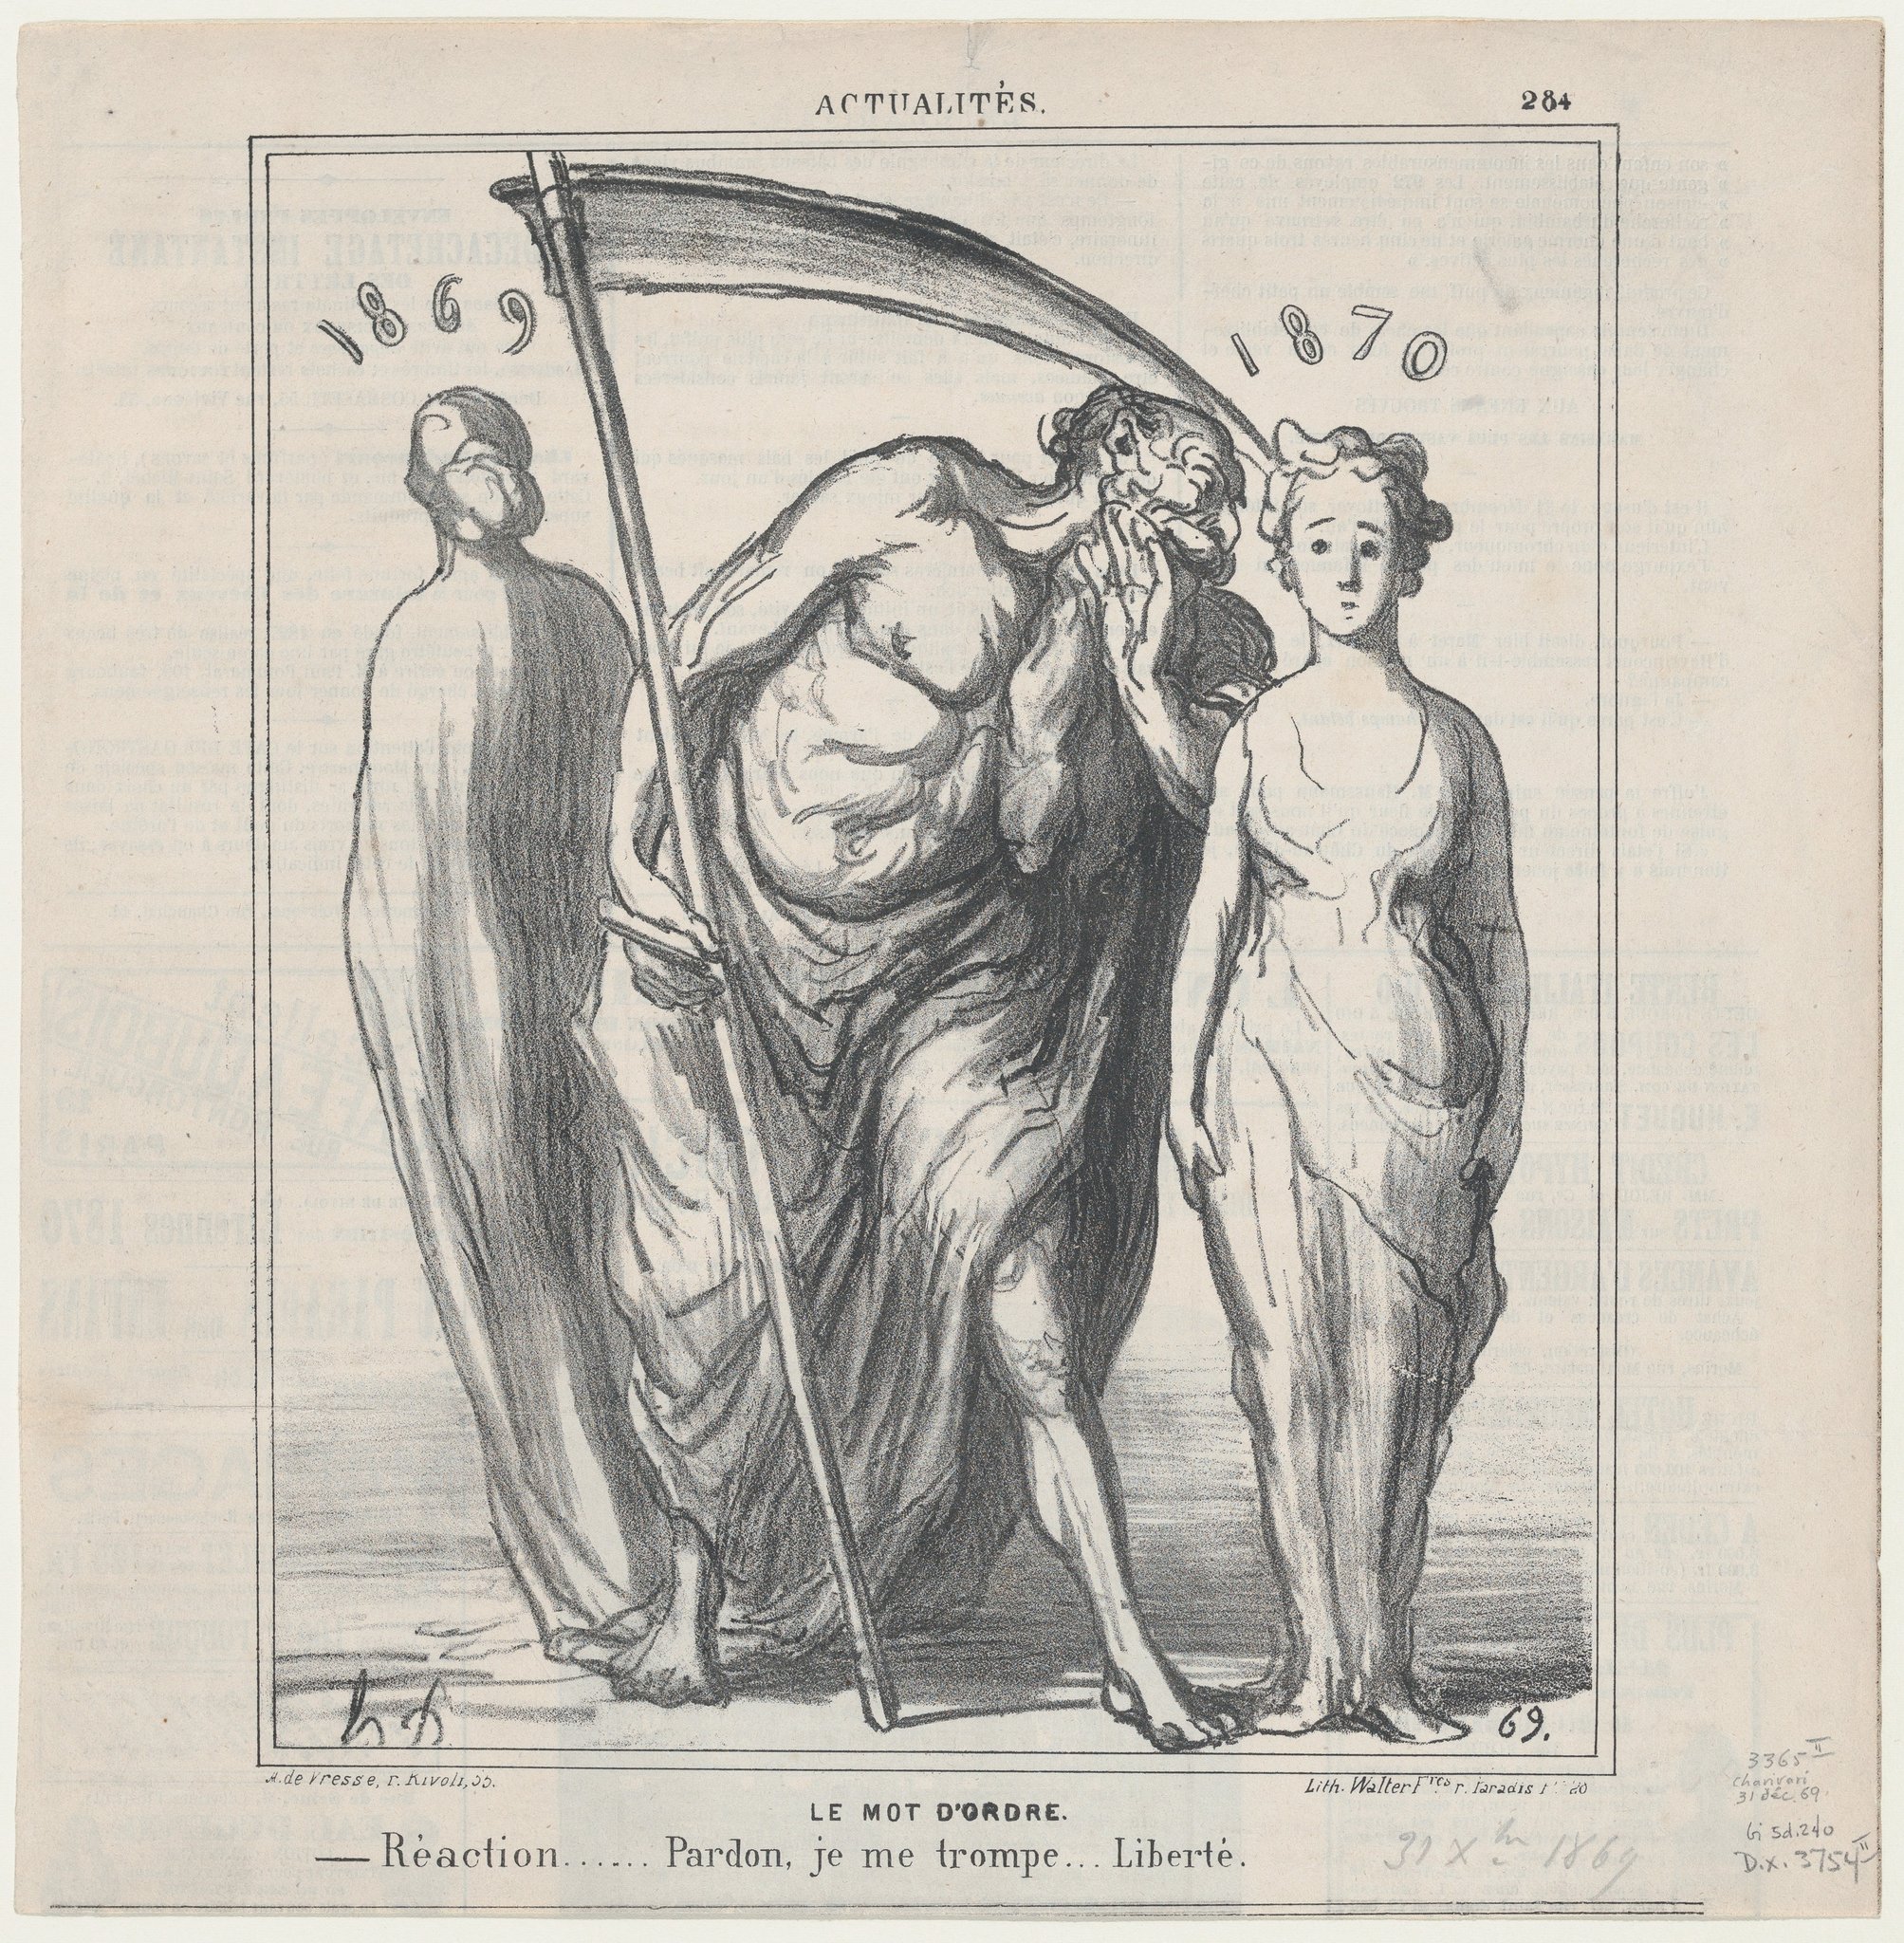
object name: print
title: The password: Reaction...... pardon me, I am mistaken... Freedom.., from 'News of the day,' published in Le Charivari, December 31, 1869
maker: honoré daumier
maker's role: artist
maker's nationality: french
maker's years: 1808-1879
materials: paper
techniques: lithograph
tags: satire,weapons,men,women